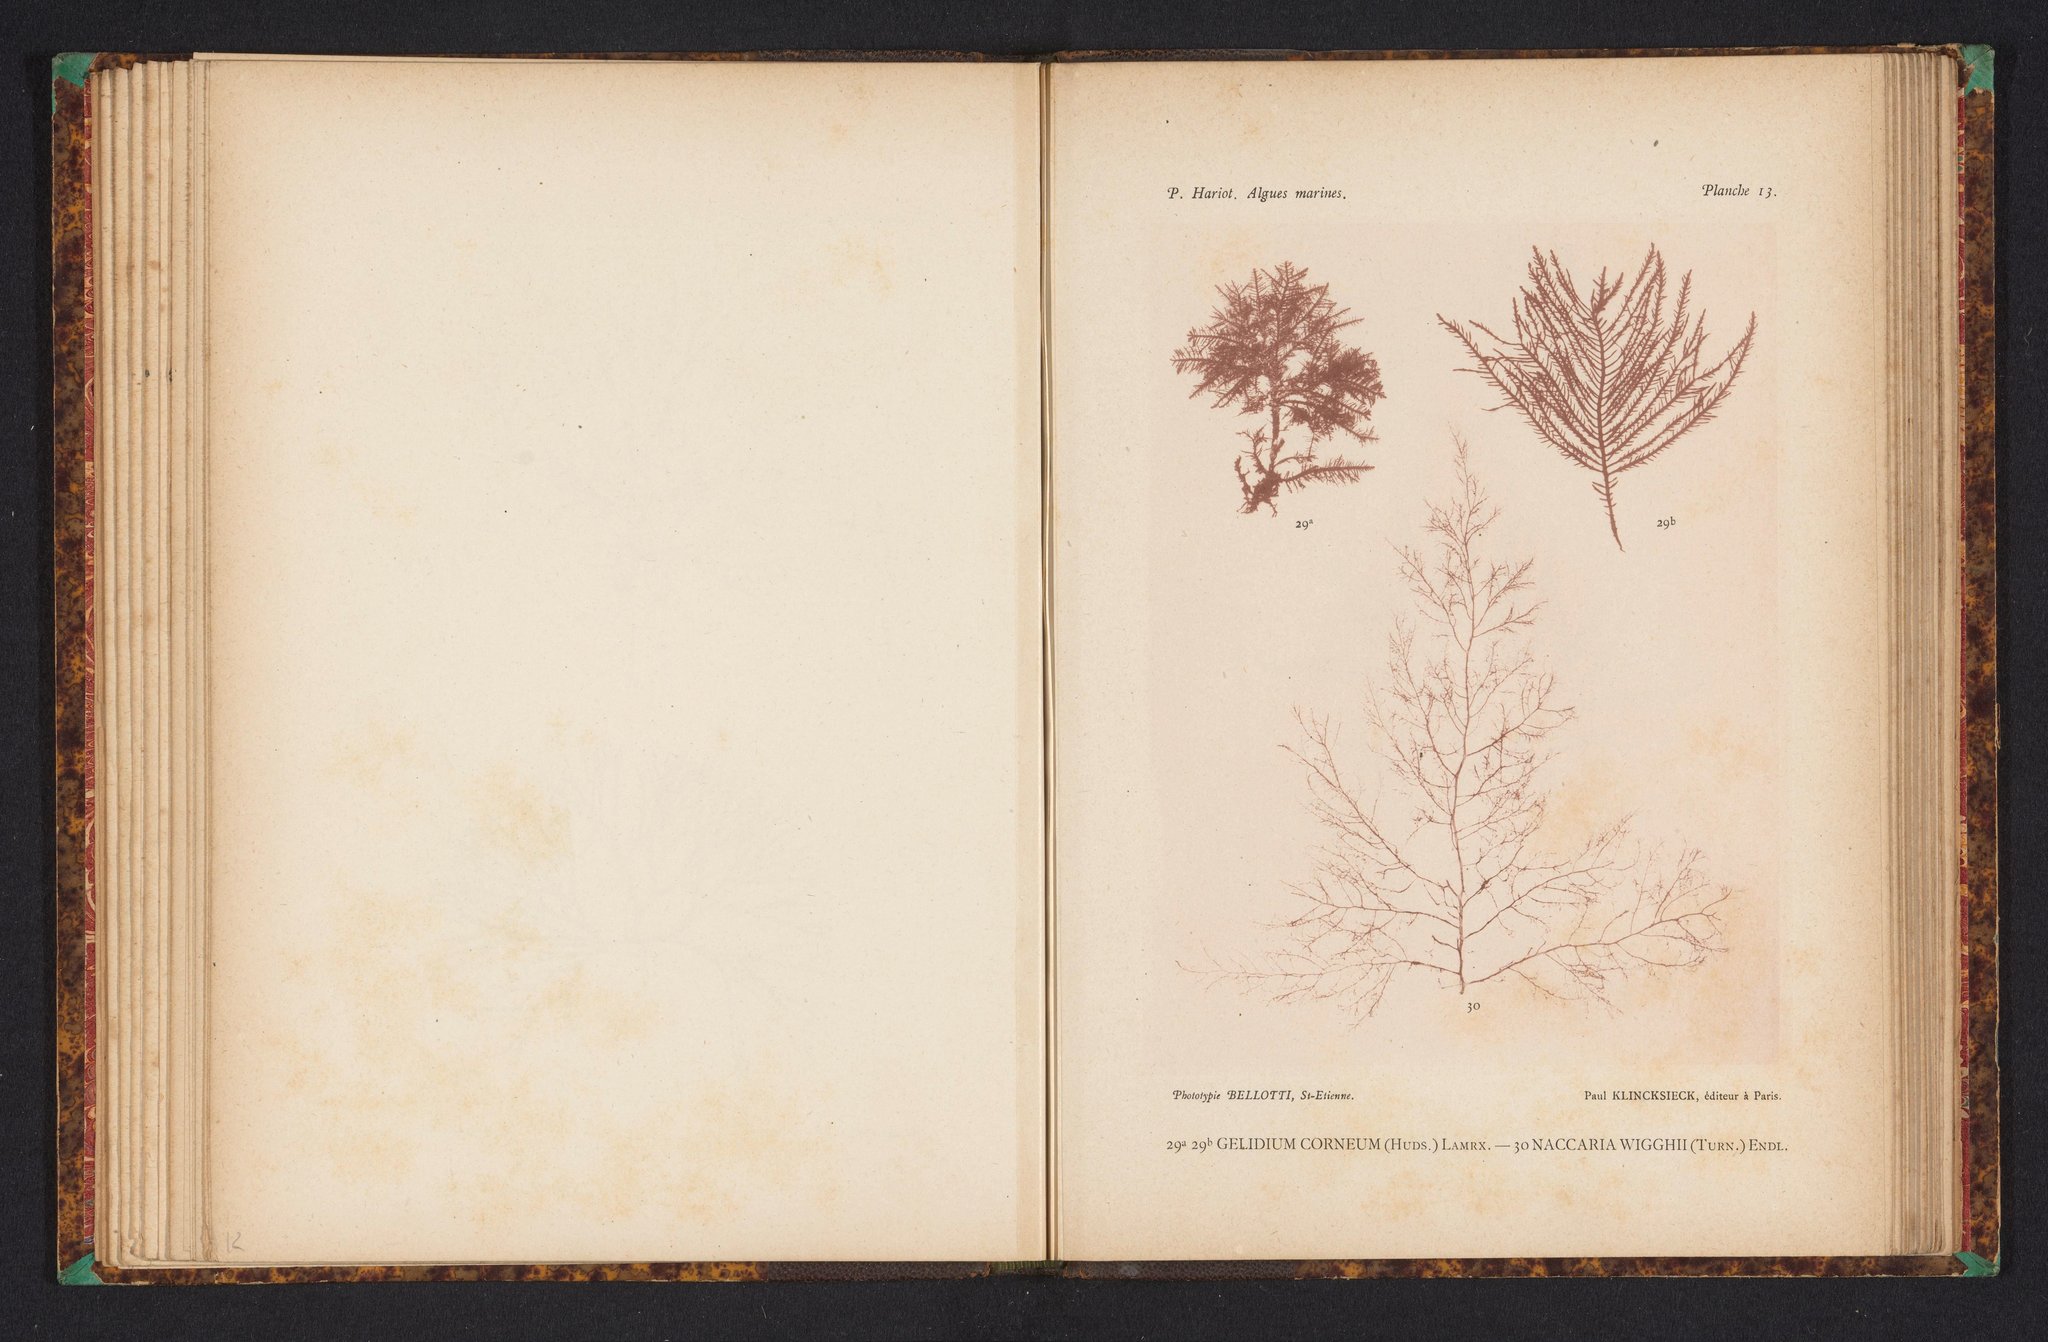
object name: photomechanical print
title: Twee soorten zeewier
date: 1882-1892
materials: paper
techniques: photograph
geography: saint-étienne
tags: algae, seaweed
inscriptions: inscription: ‘Gelidium (...) wigghii (Turn.) Endi.’, number: ‘29a (...) 30’, number: ‘Planche 13.’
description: (29a) en (29b) is Gelidium corneum, (30) is Naccaria wiggii.